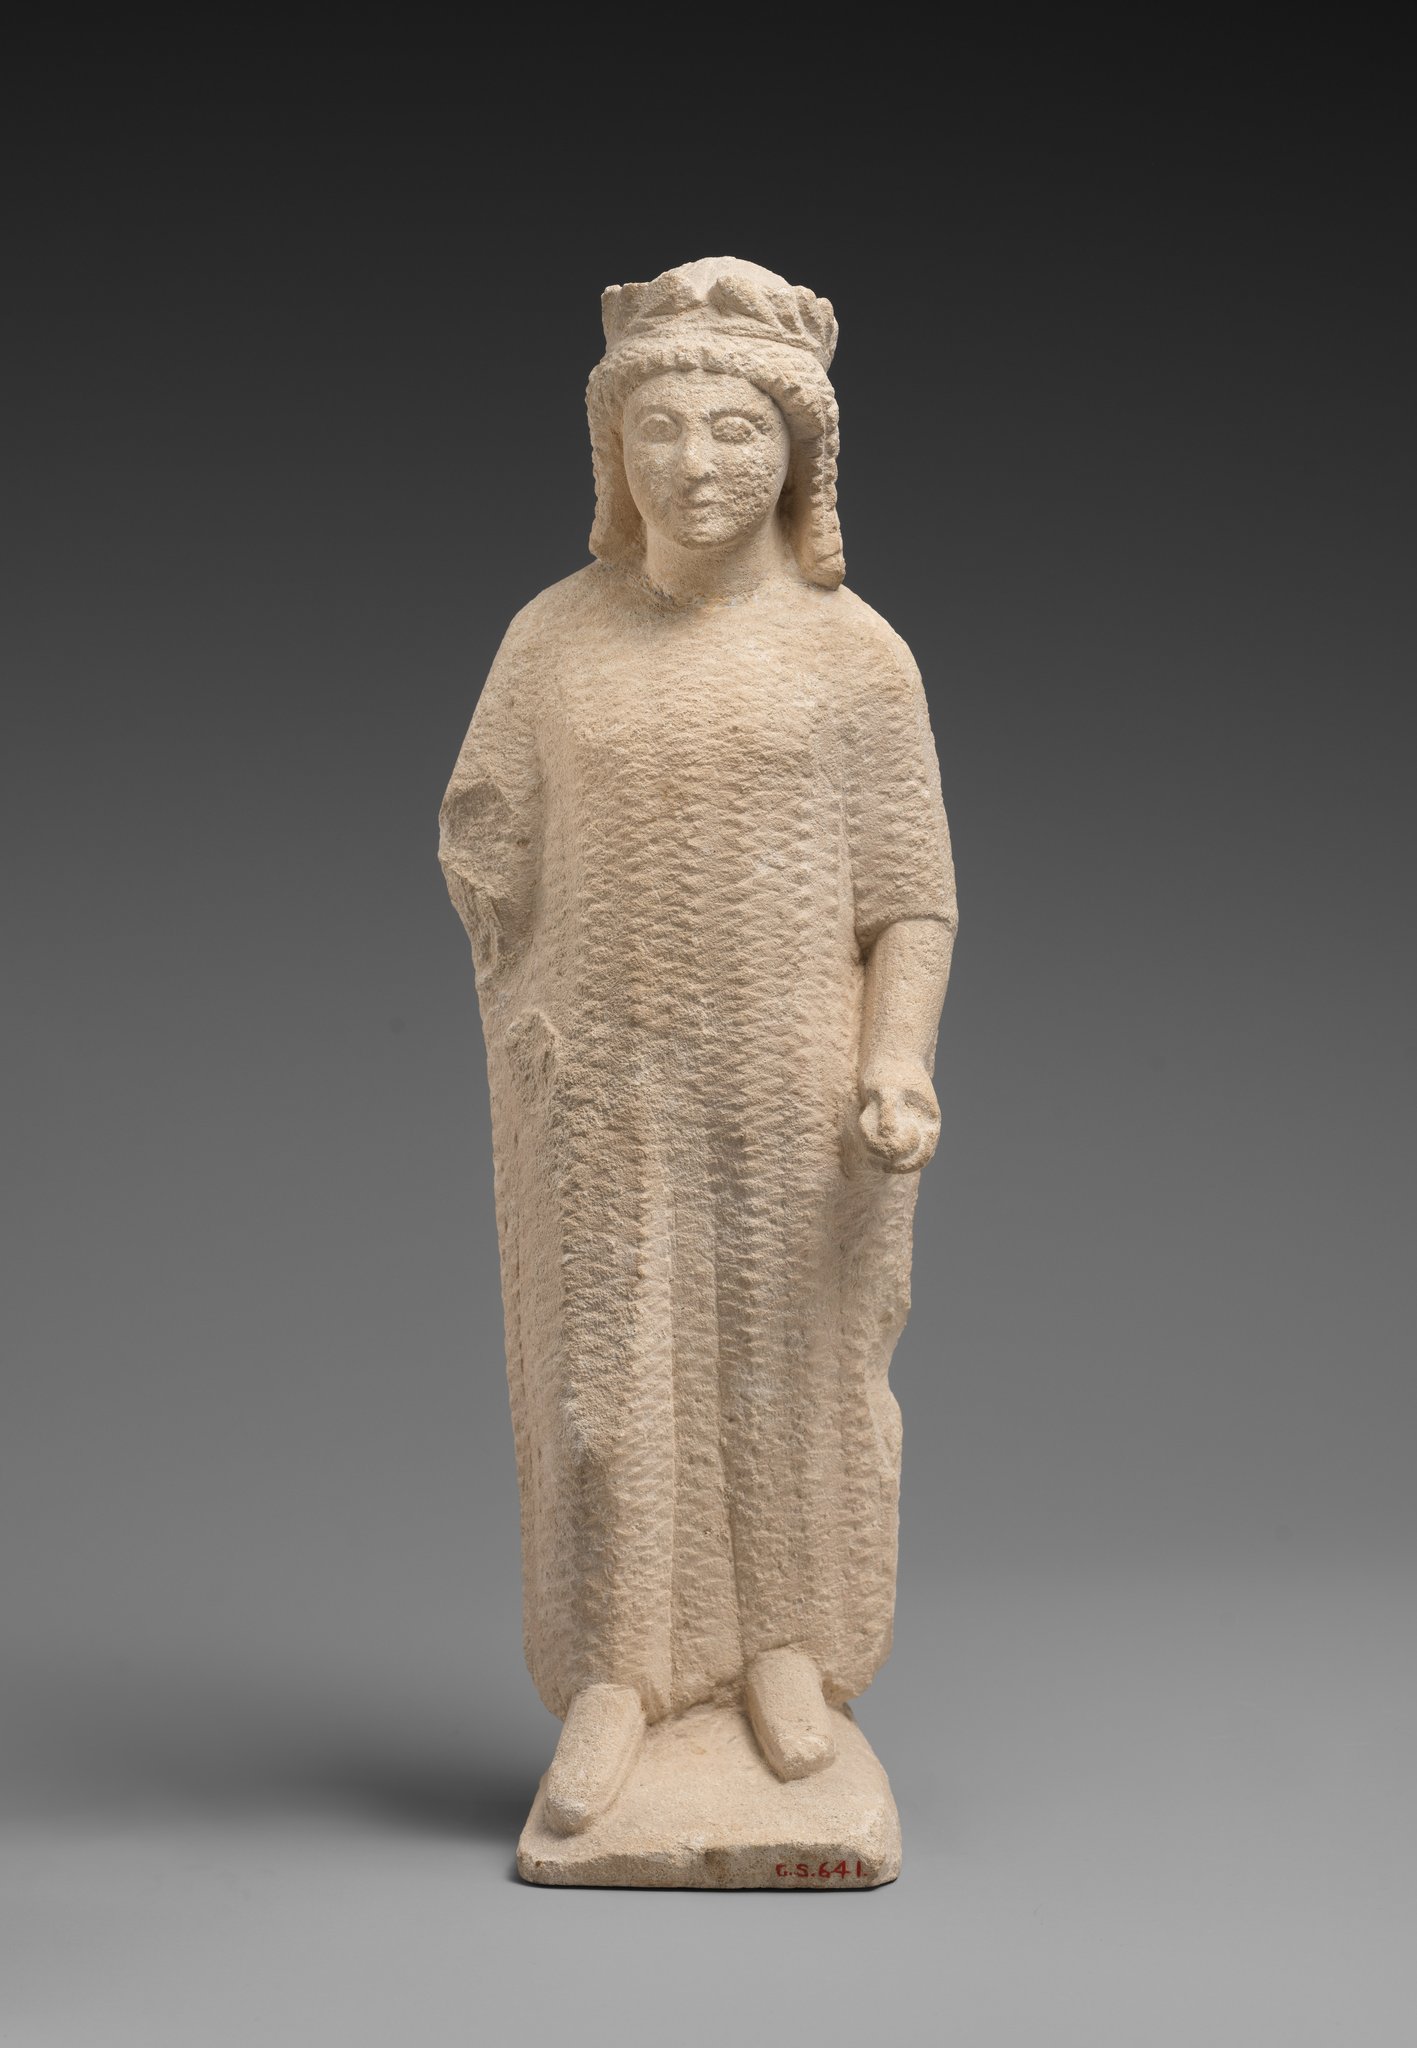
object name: statuette of a votary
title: Limestone statuette of a boy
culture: cypriot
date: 450-426 BCE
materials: limestone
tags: boys